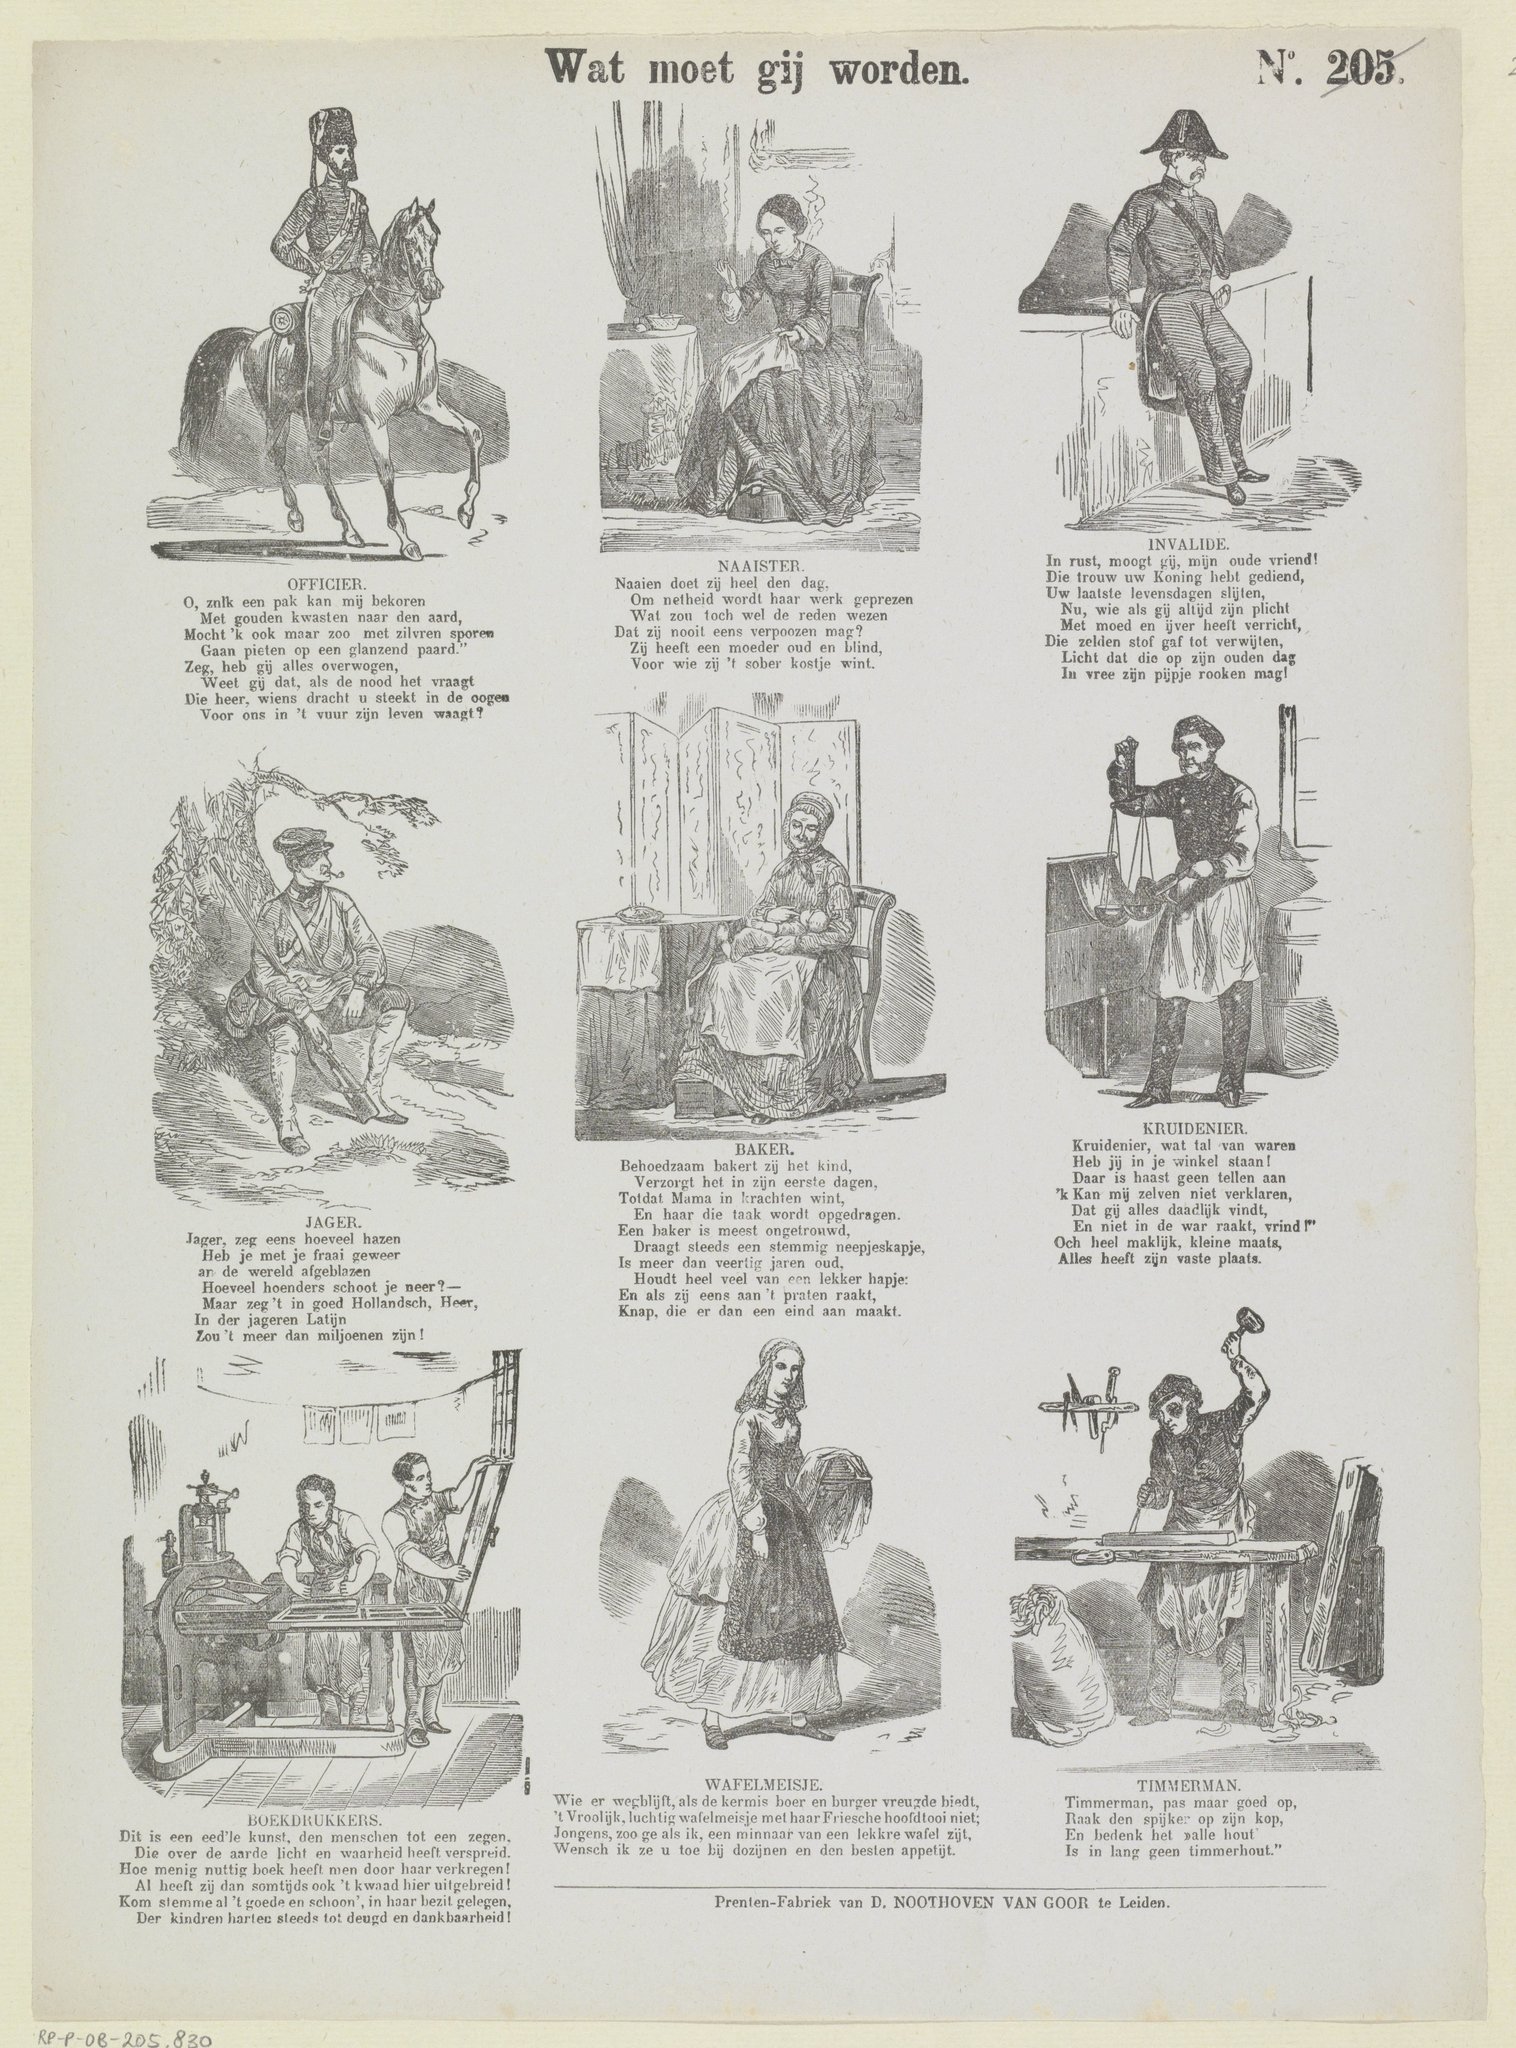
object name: print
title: Wat moet gij worden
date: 1850-1881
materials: paper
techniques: letterpress printing, engraving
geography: netherlands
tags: carpenter, craft-production, skilled handiwork, working class, labourers, the soldier; the soldier's life, crafts and industries, merchant, salesman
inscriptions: collector's mark: Lugt 2760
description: Blad met 9 voorstellingen van ambachtslieden en beroepen, zoals naaister, jager en timmerman. Onder elke voorstelling een vers. Genummerd rechtsboven: No. 205.